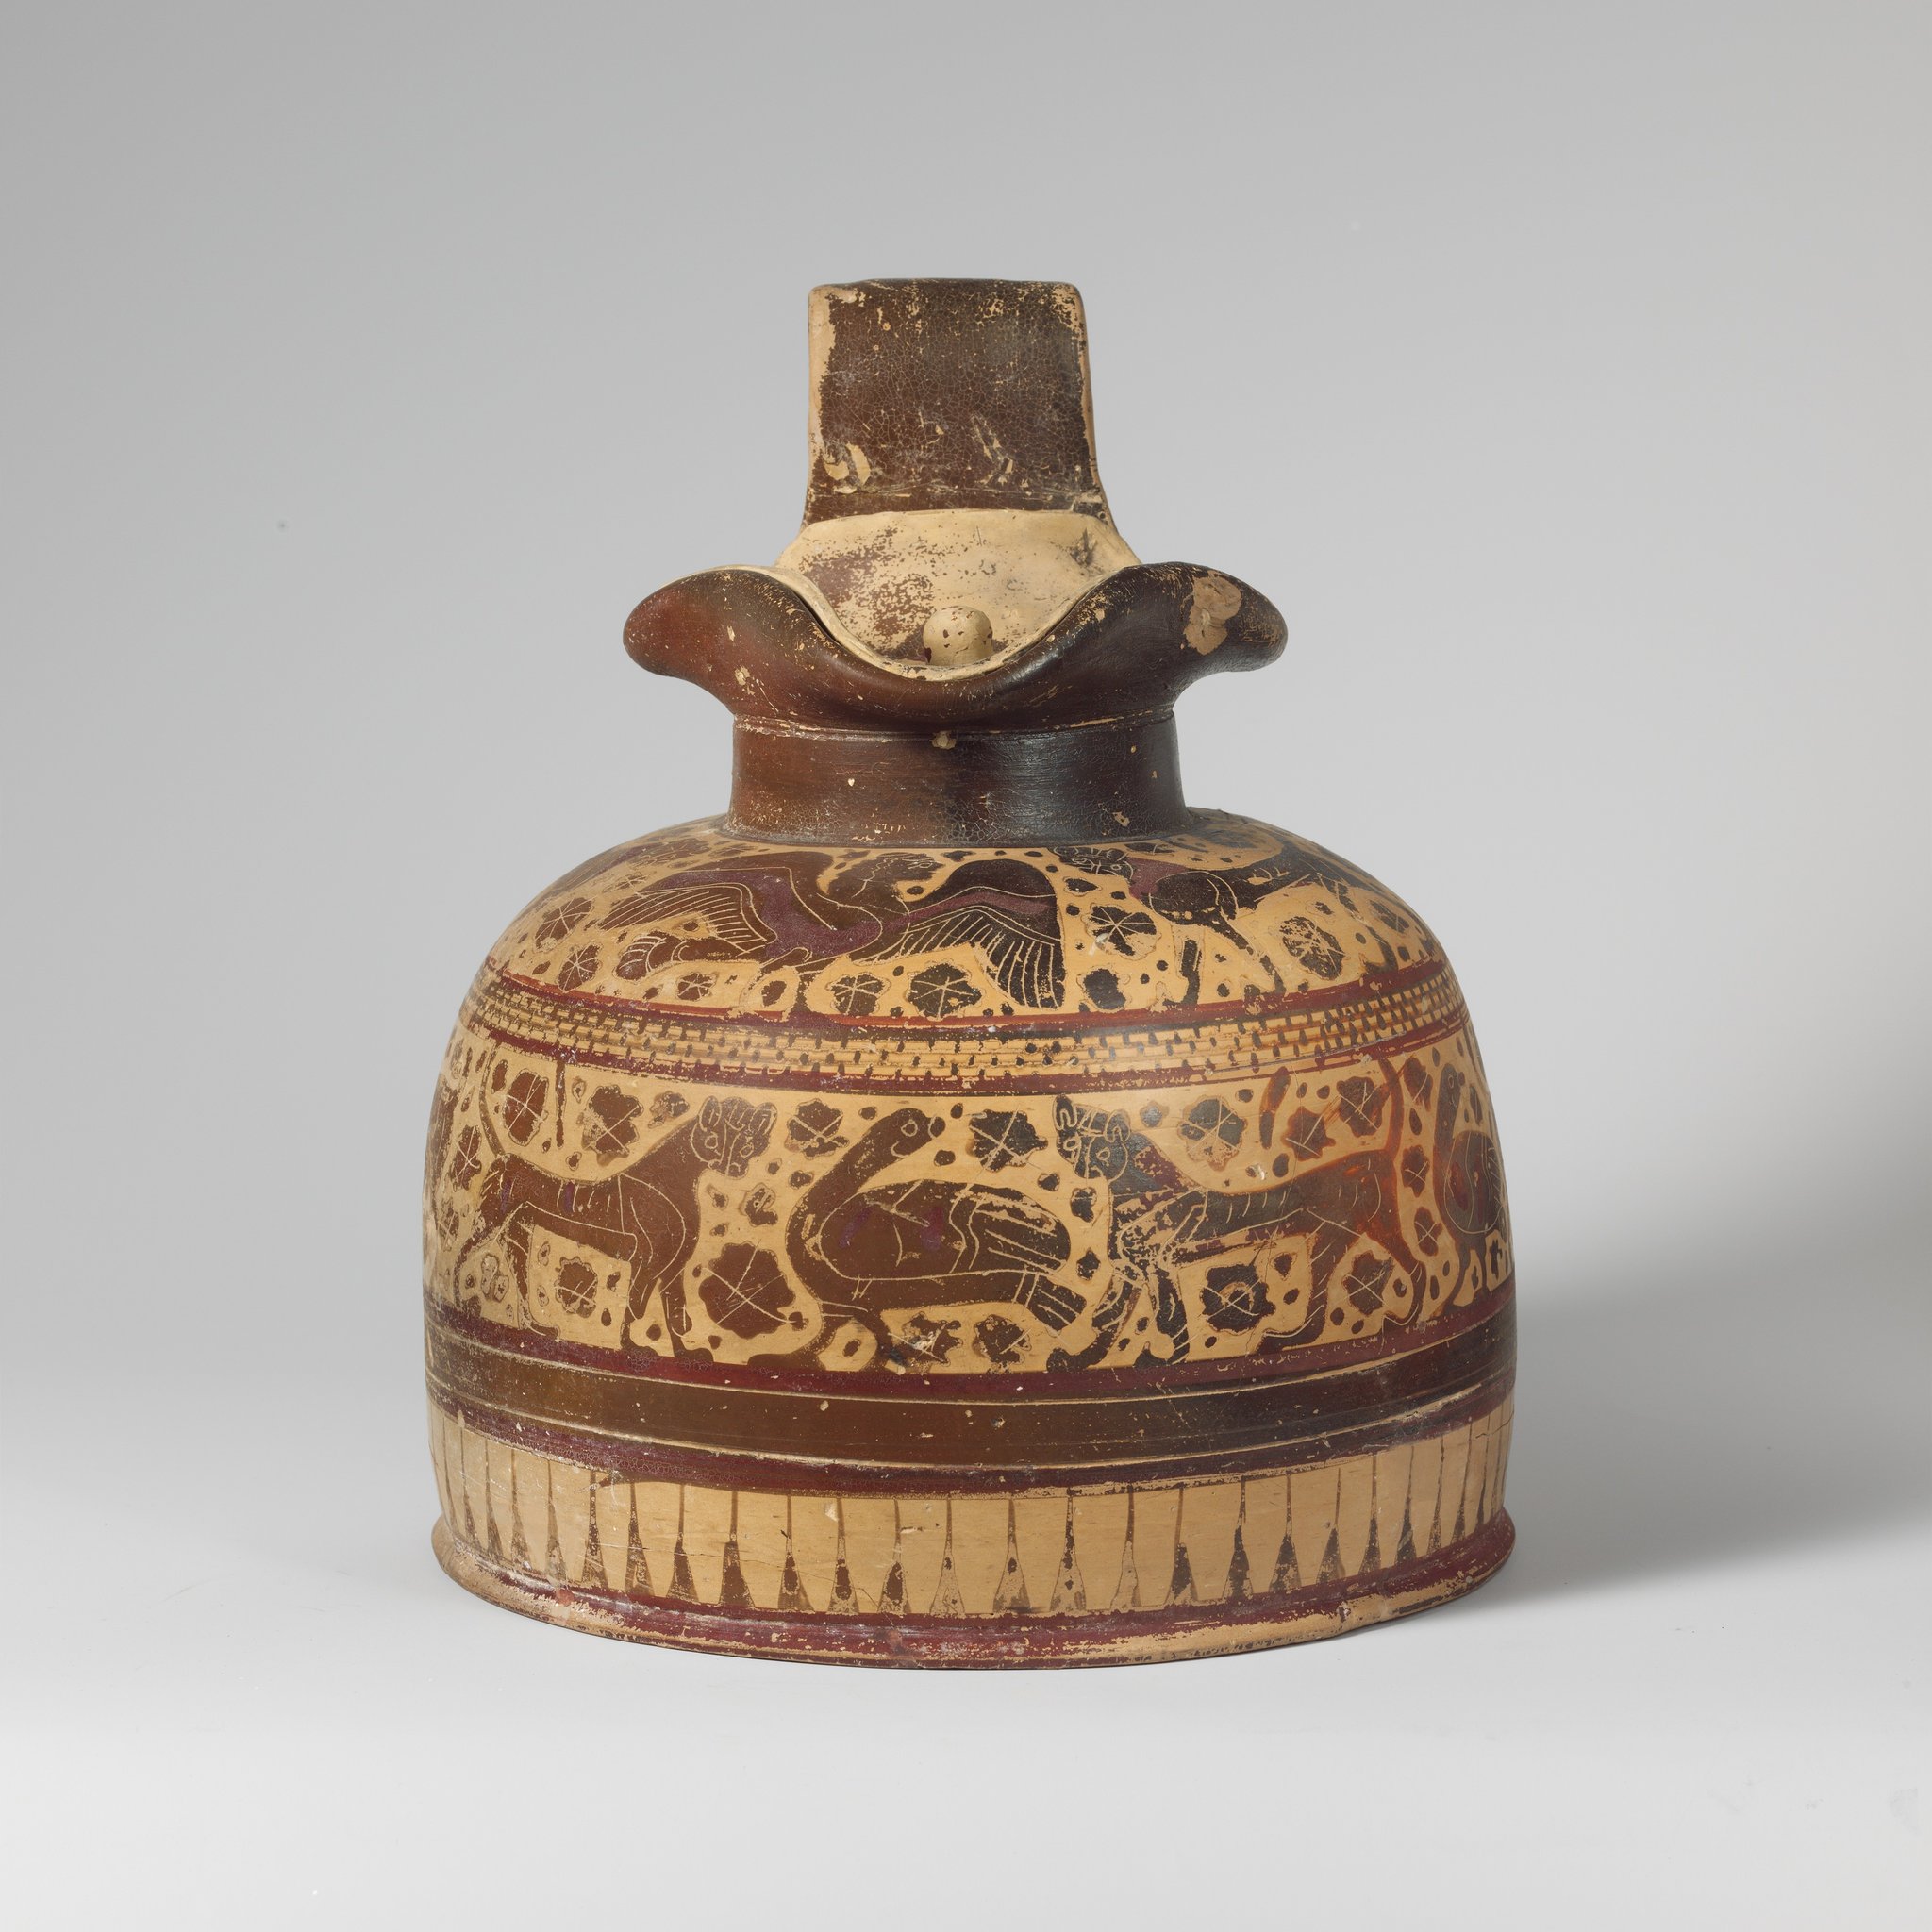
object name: oinochoe with lid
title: Terracotta oinochoe (jug) with lid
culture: greek, corinthian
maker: canessa painter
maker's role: artist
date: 590-570 BCE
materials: terracotta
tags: animals,birds